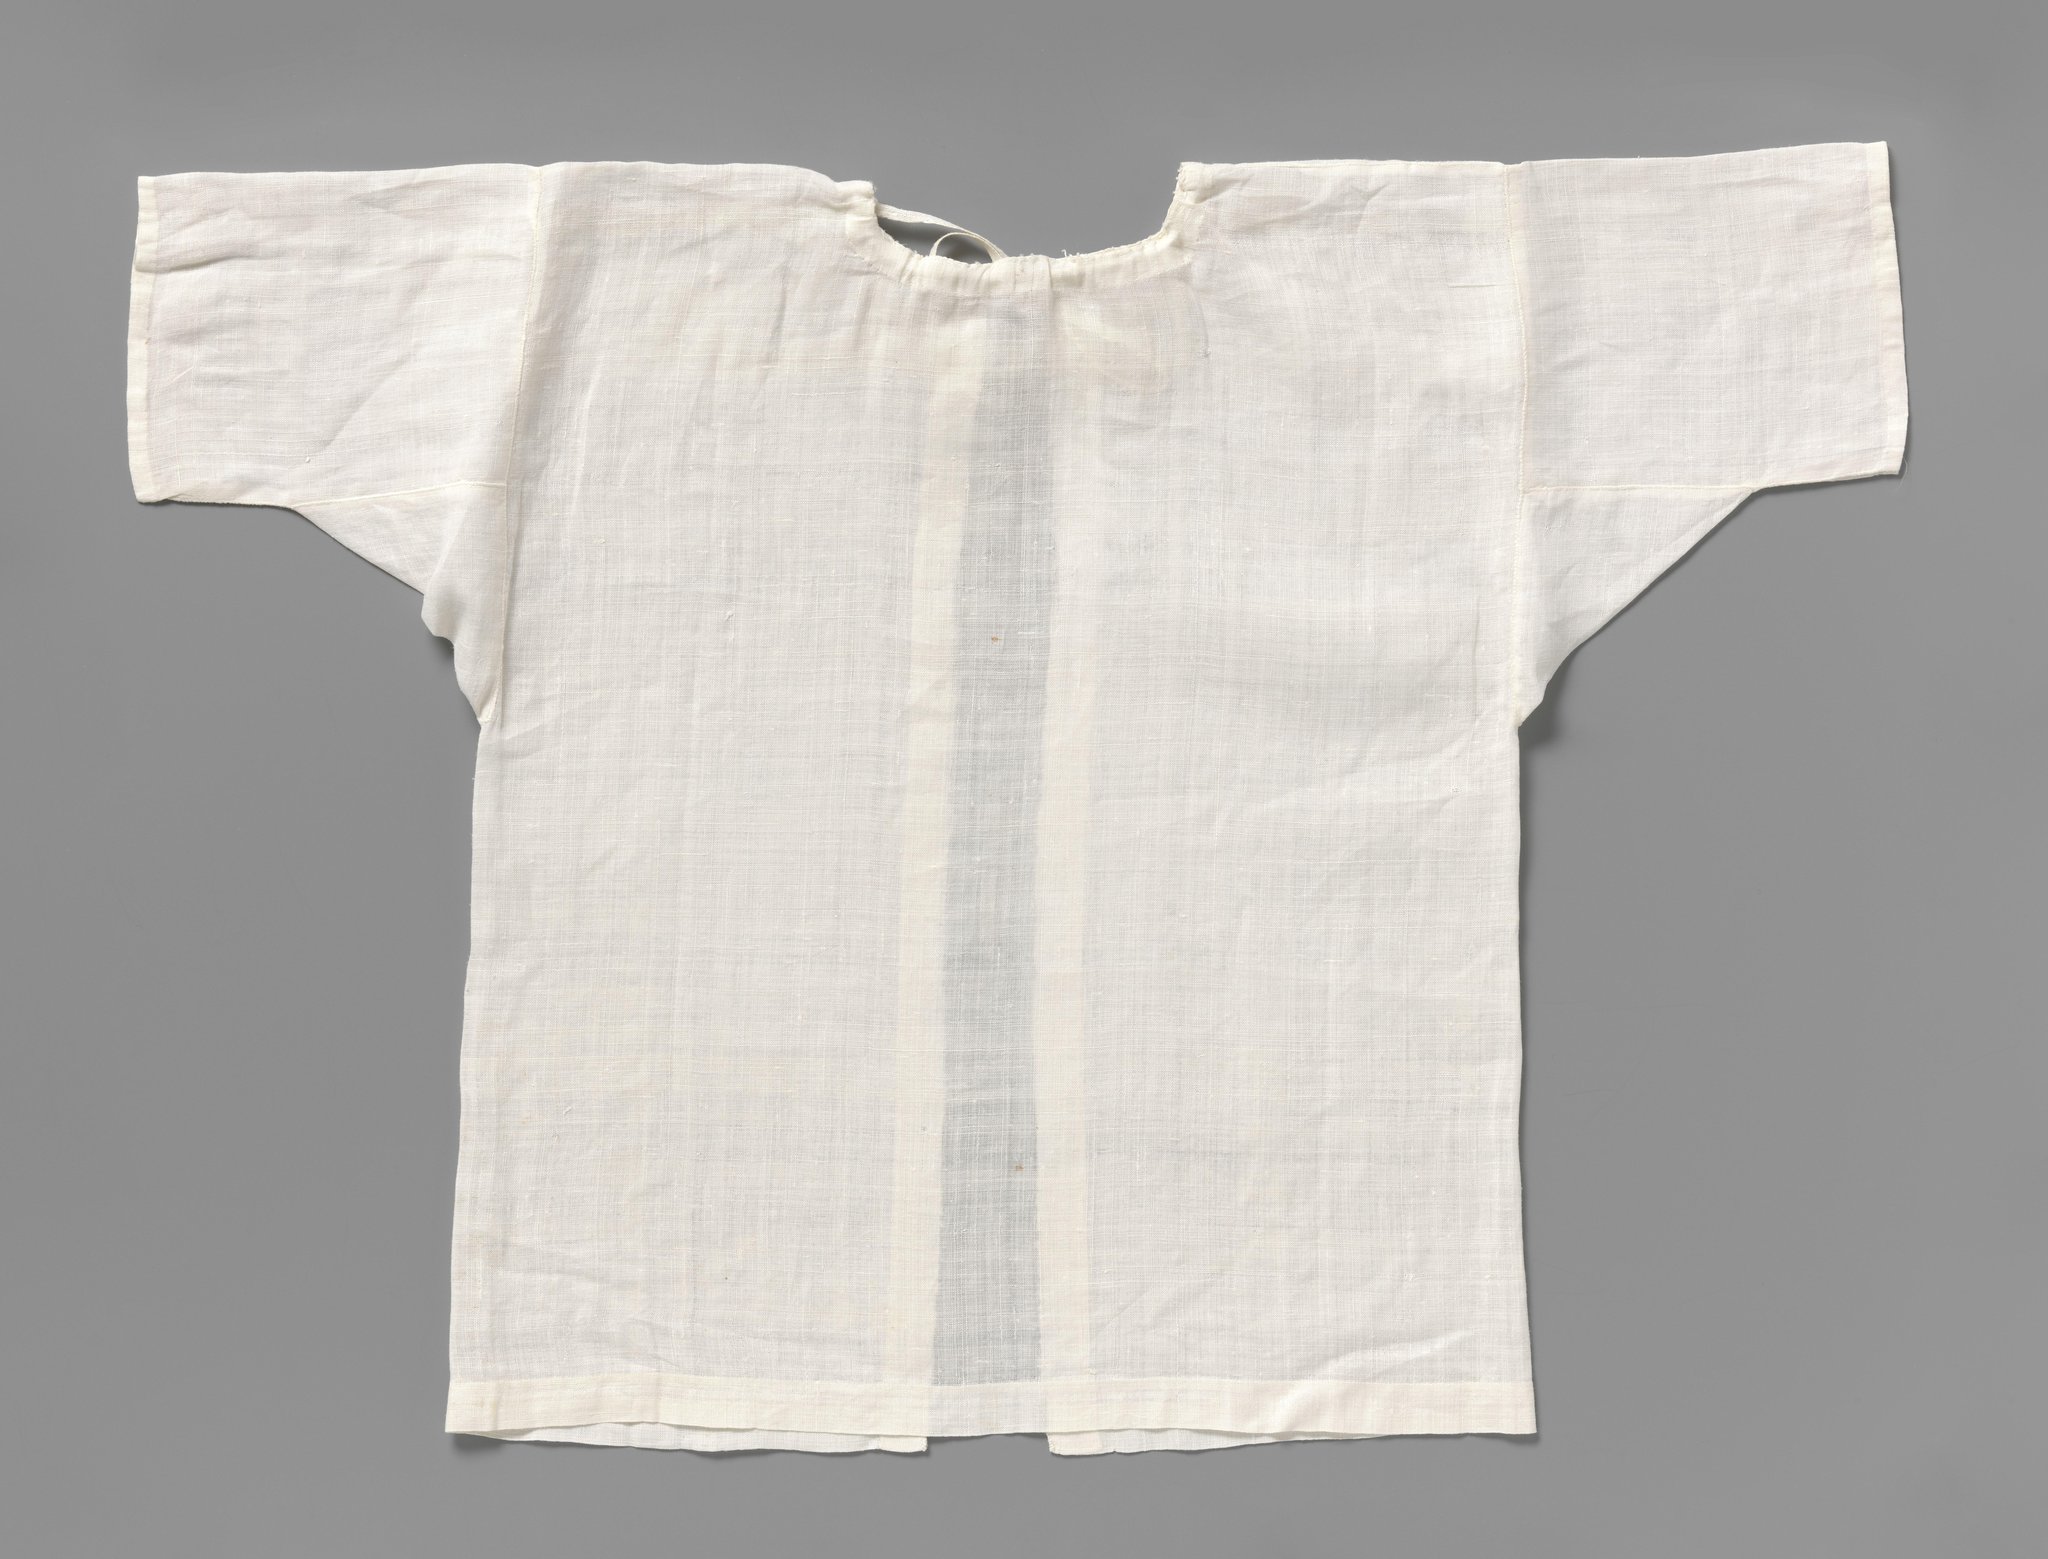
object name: underwear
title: Babyhemd van linnen batist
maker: Anonymous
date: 1725-1775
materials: textile, linen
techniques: cross stitching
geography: netherlands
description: Babyhemdje van linne bastist, gemerkt: P (of J?) S=(Six). Lodweijk XV of Lodewijk XVI(?) Model: Handgenaaid. Rechte panden zonder ziujnaden. Ronde hals. Rechte schouderrand. Korte, wijde, rechte mouwen met een grote vierkante spie. Vanachter open met brede zoom rondom. Sluiting met een bandje in de hals. Versiering. Resten van aannaaisels, kantstrookje ?, langs de opening. Merken. Onder in de rugpandhoeken zijn in rode kruissteek de initialen P(of Jan) S (voor Six) geborduurd.Toestand: In 1979 gewassen. De rode merkjes zijn verbleekt. In de rug een gaatje. De naden van de openstaande panden zijn bij het aftornen van een versiering gerafeld.